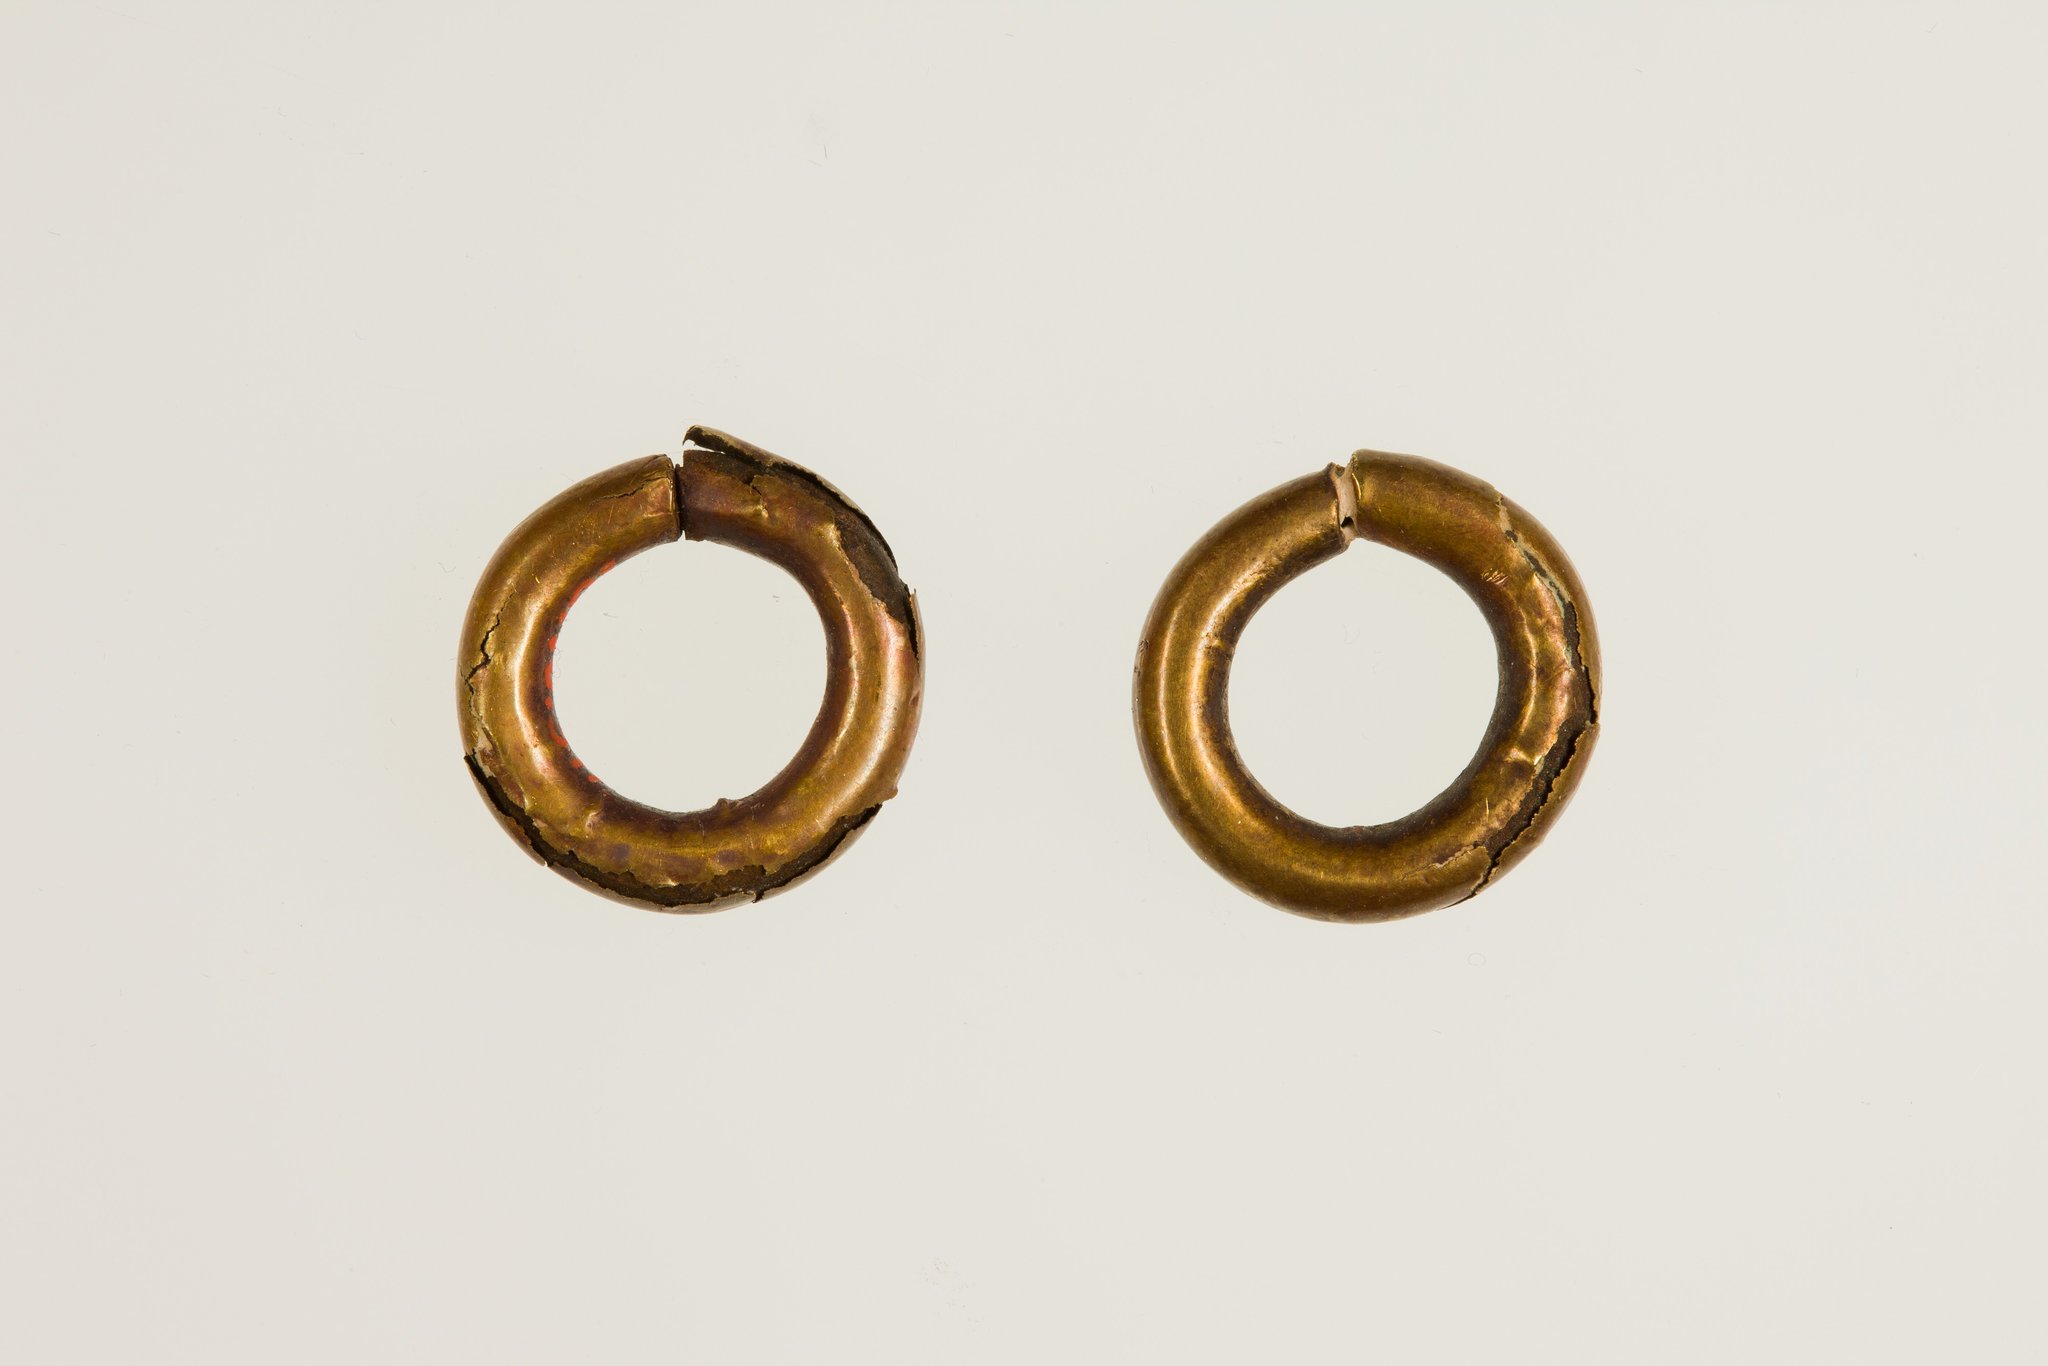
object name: earring, pennanular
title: Pair of Earrings (with 16.10.310)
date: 1635-1458 BCE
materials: bronze, copper alloy, gold foil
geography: egypt